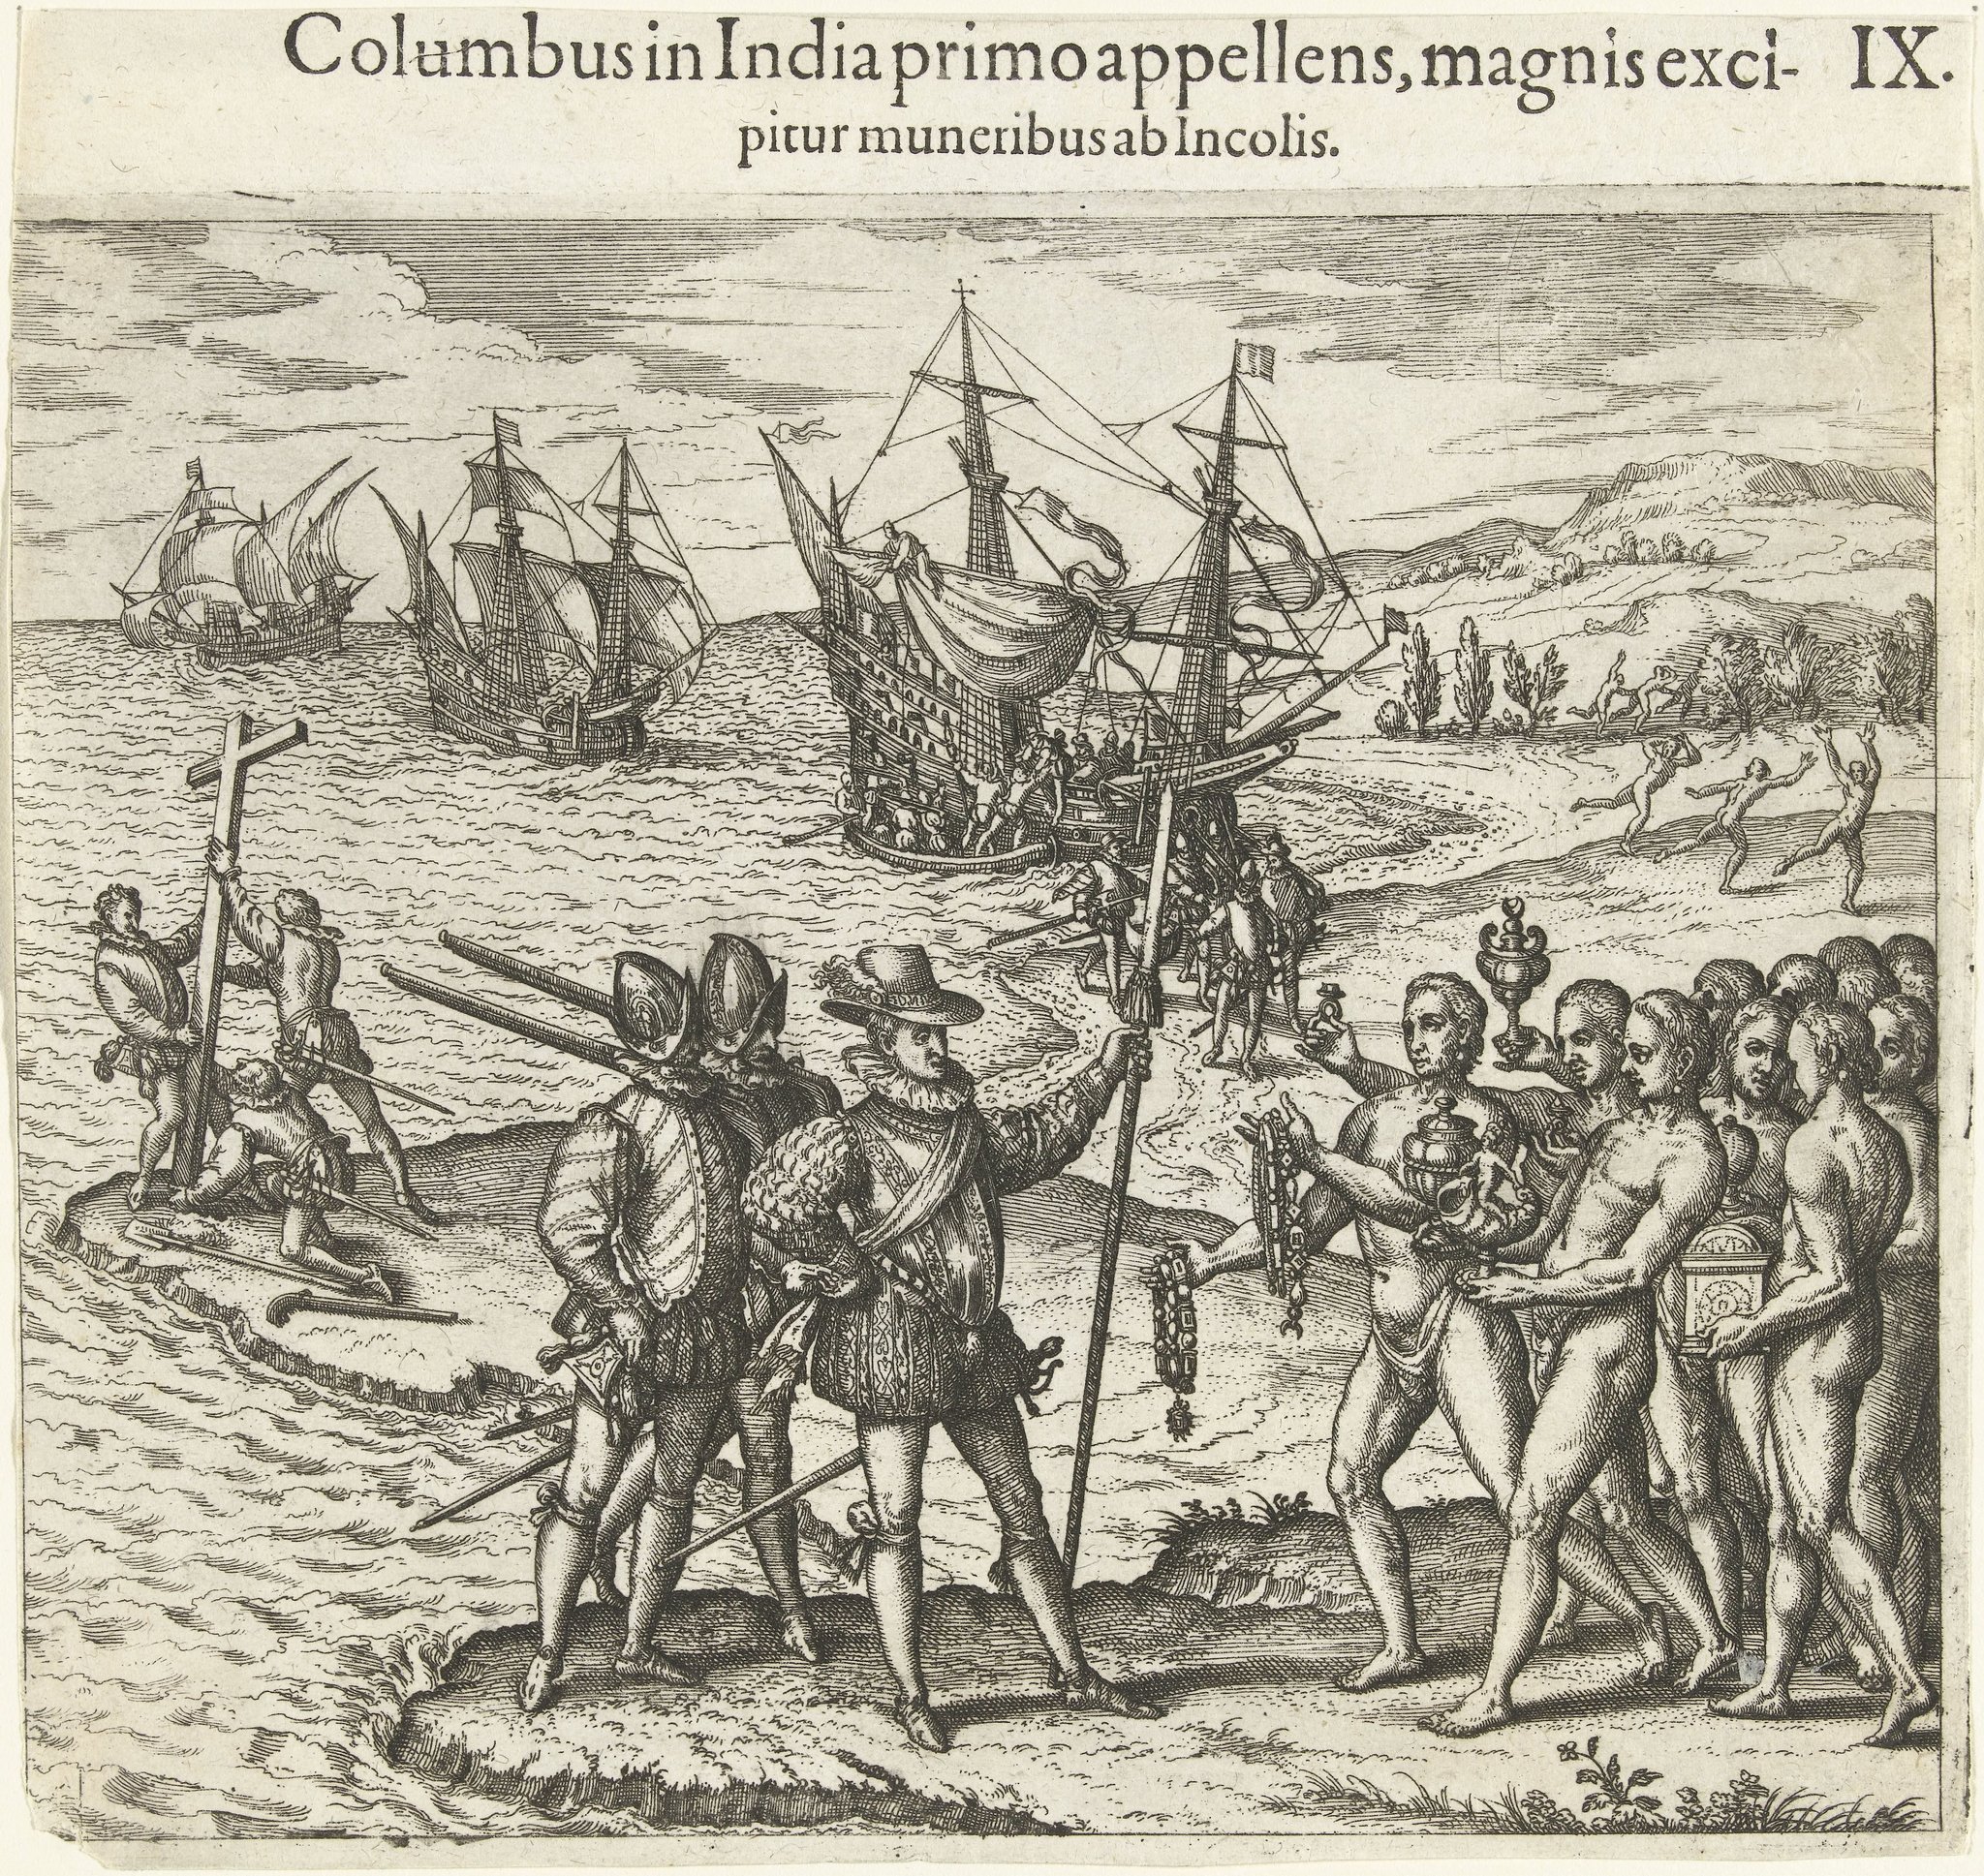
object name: book illustration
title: India occidentalis IV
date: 1594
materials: paper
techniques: etching, letterpress printing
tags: historical persons, indigenous peoples of central america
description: Afkomstig uit: Collectiones peregrinationum in Indiam occidentalem, dl. 4: Girolamo Benzoni, Americae pars quarta. Sive, Insignis & admiranda historia de reperta primum occidentali India à Christophoro Columbo. Frankfurt am Main: T. de Bry, 1594.